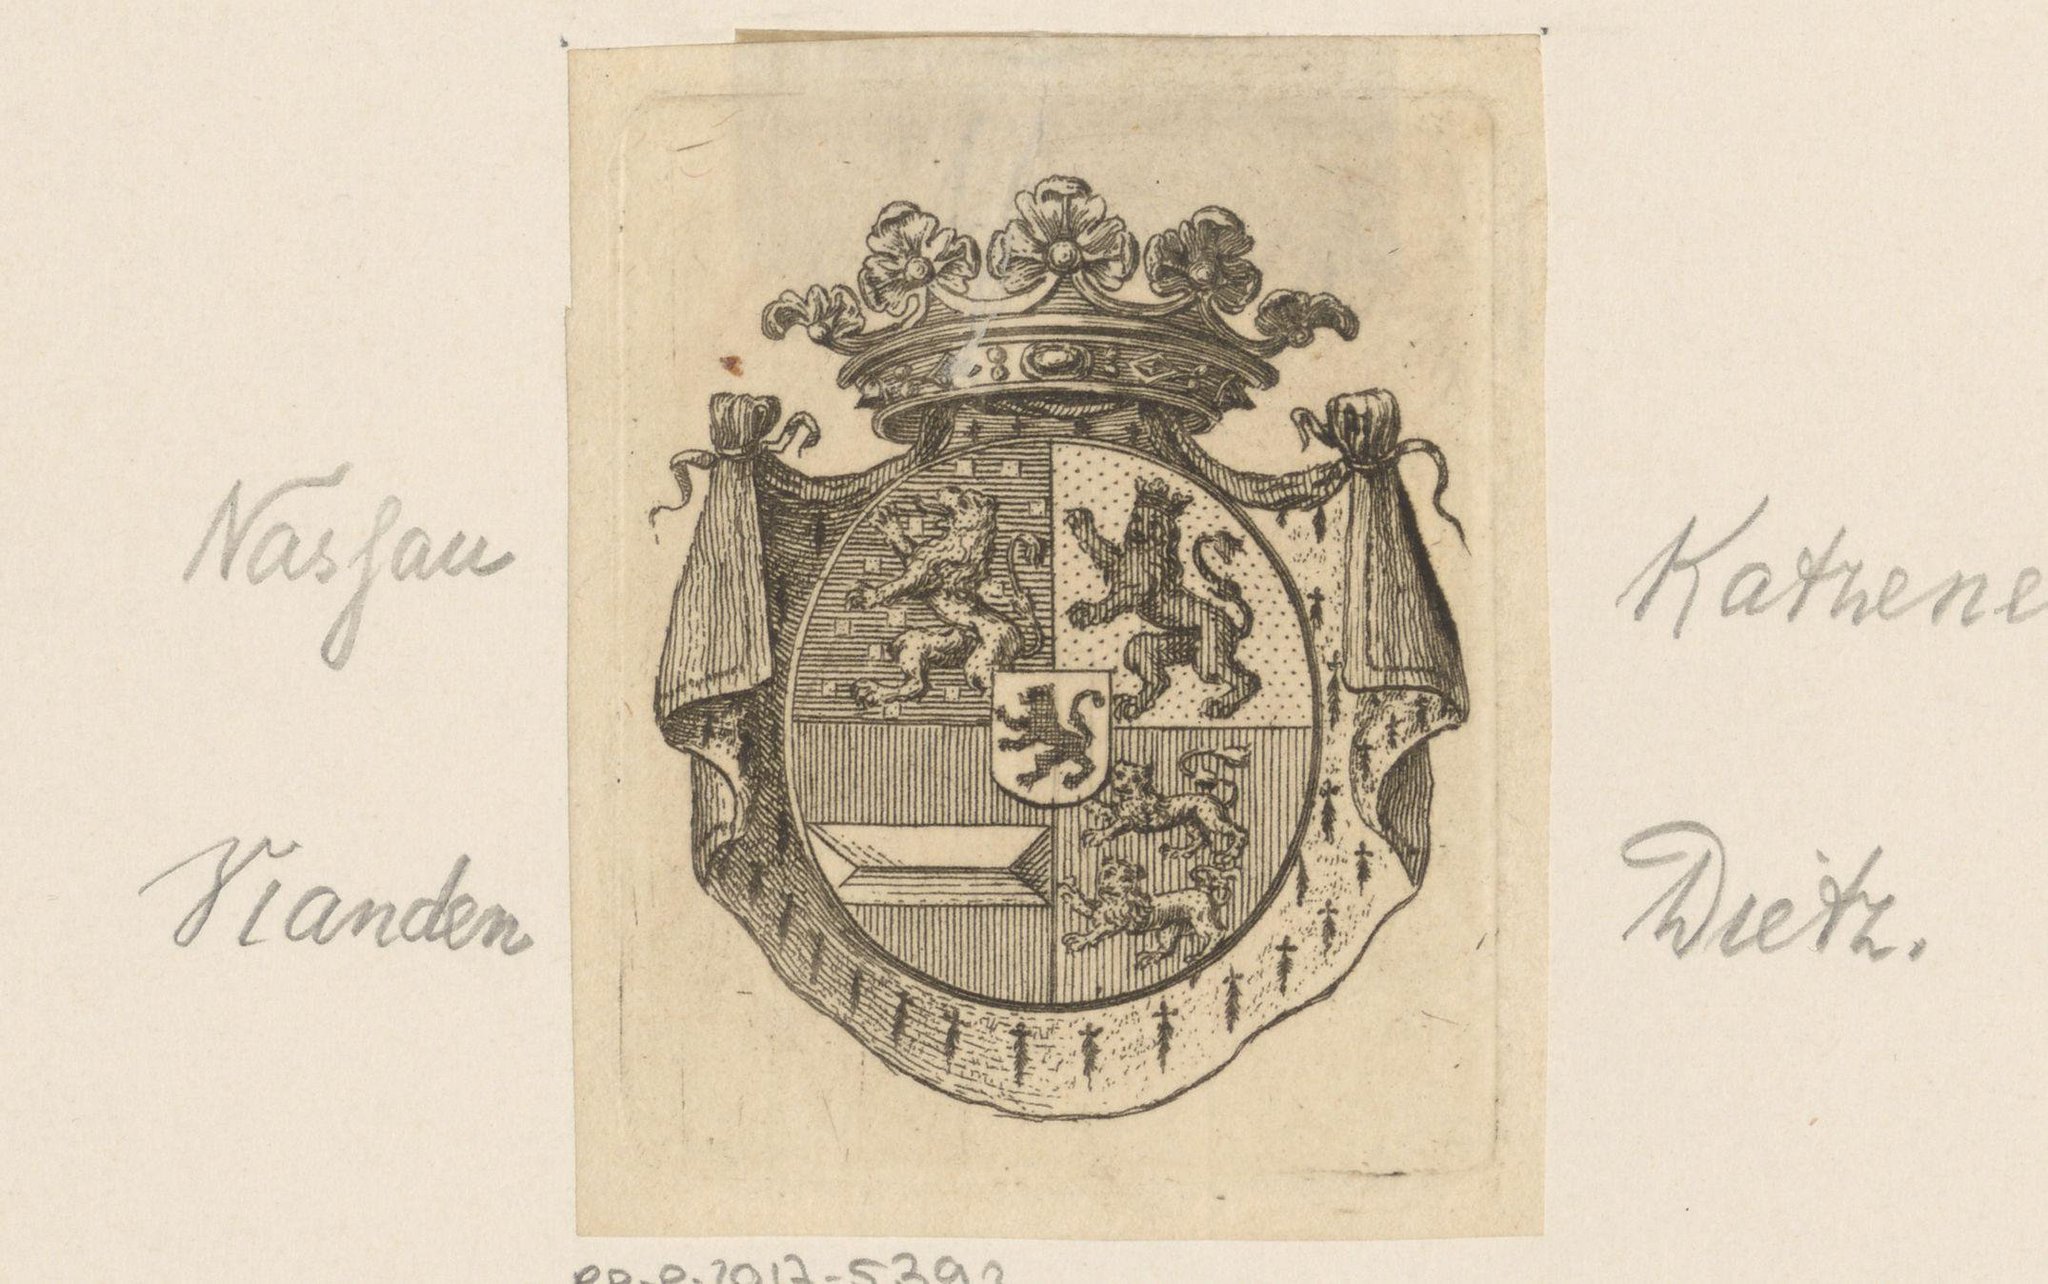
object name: bookplate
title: Ex libris van Van Nassau la Lecq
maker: Anonymous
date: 1650-1799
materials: paper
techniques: etching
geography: netherlands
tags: beasts of prey, predatory animals: lion, armorial bearing, heraldry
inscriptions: inscription: ‘Rietstap, II, 297.’